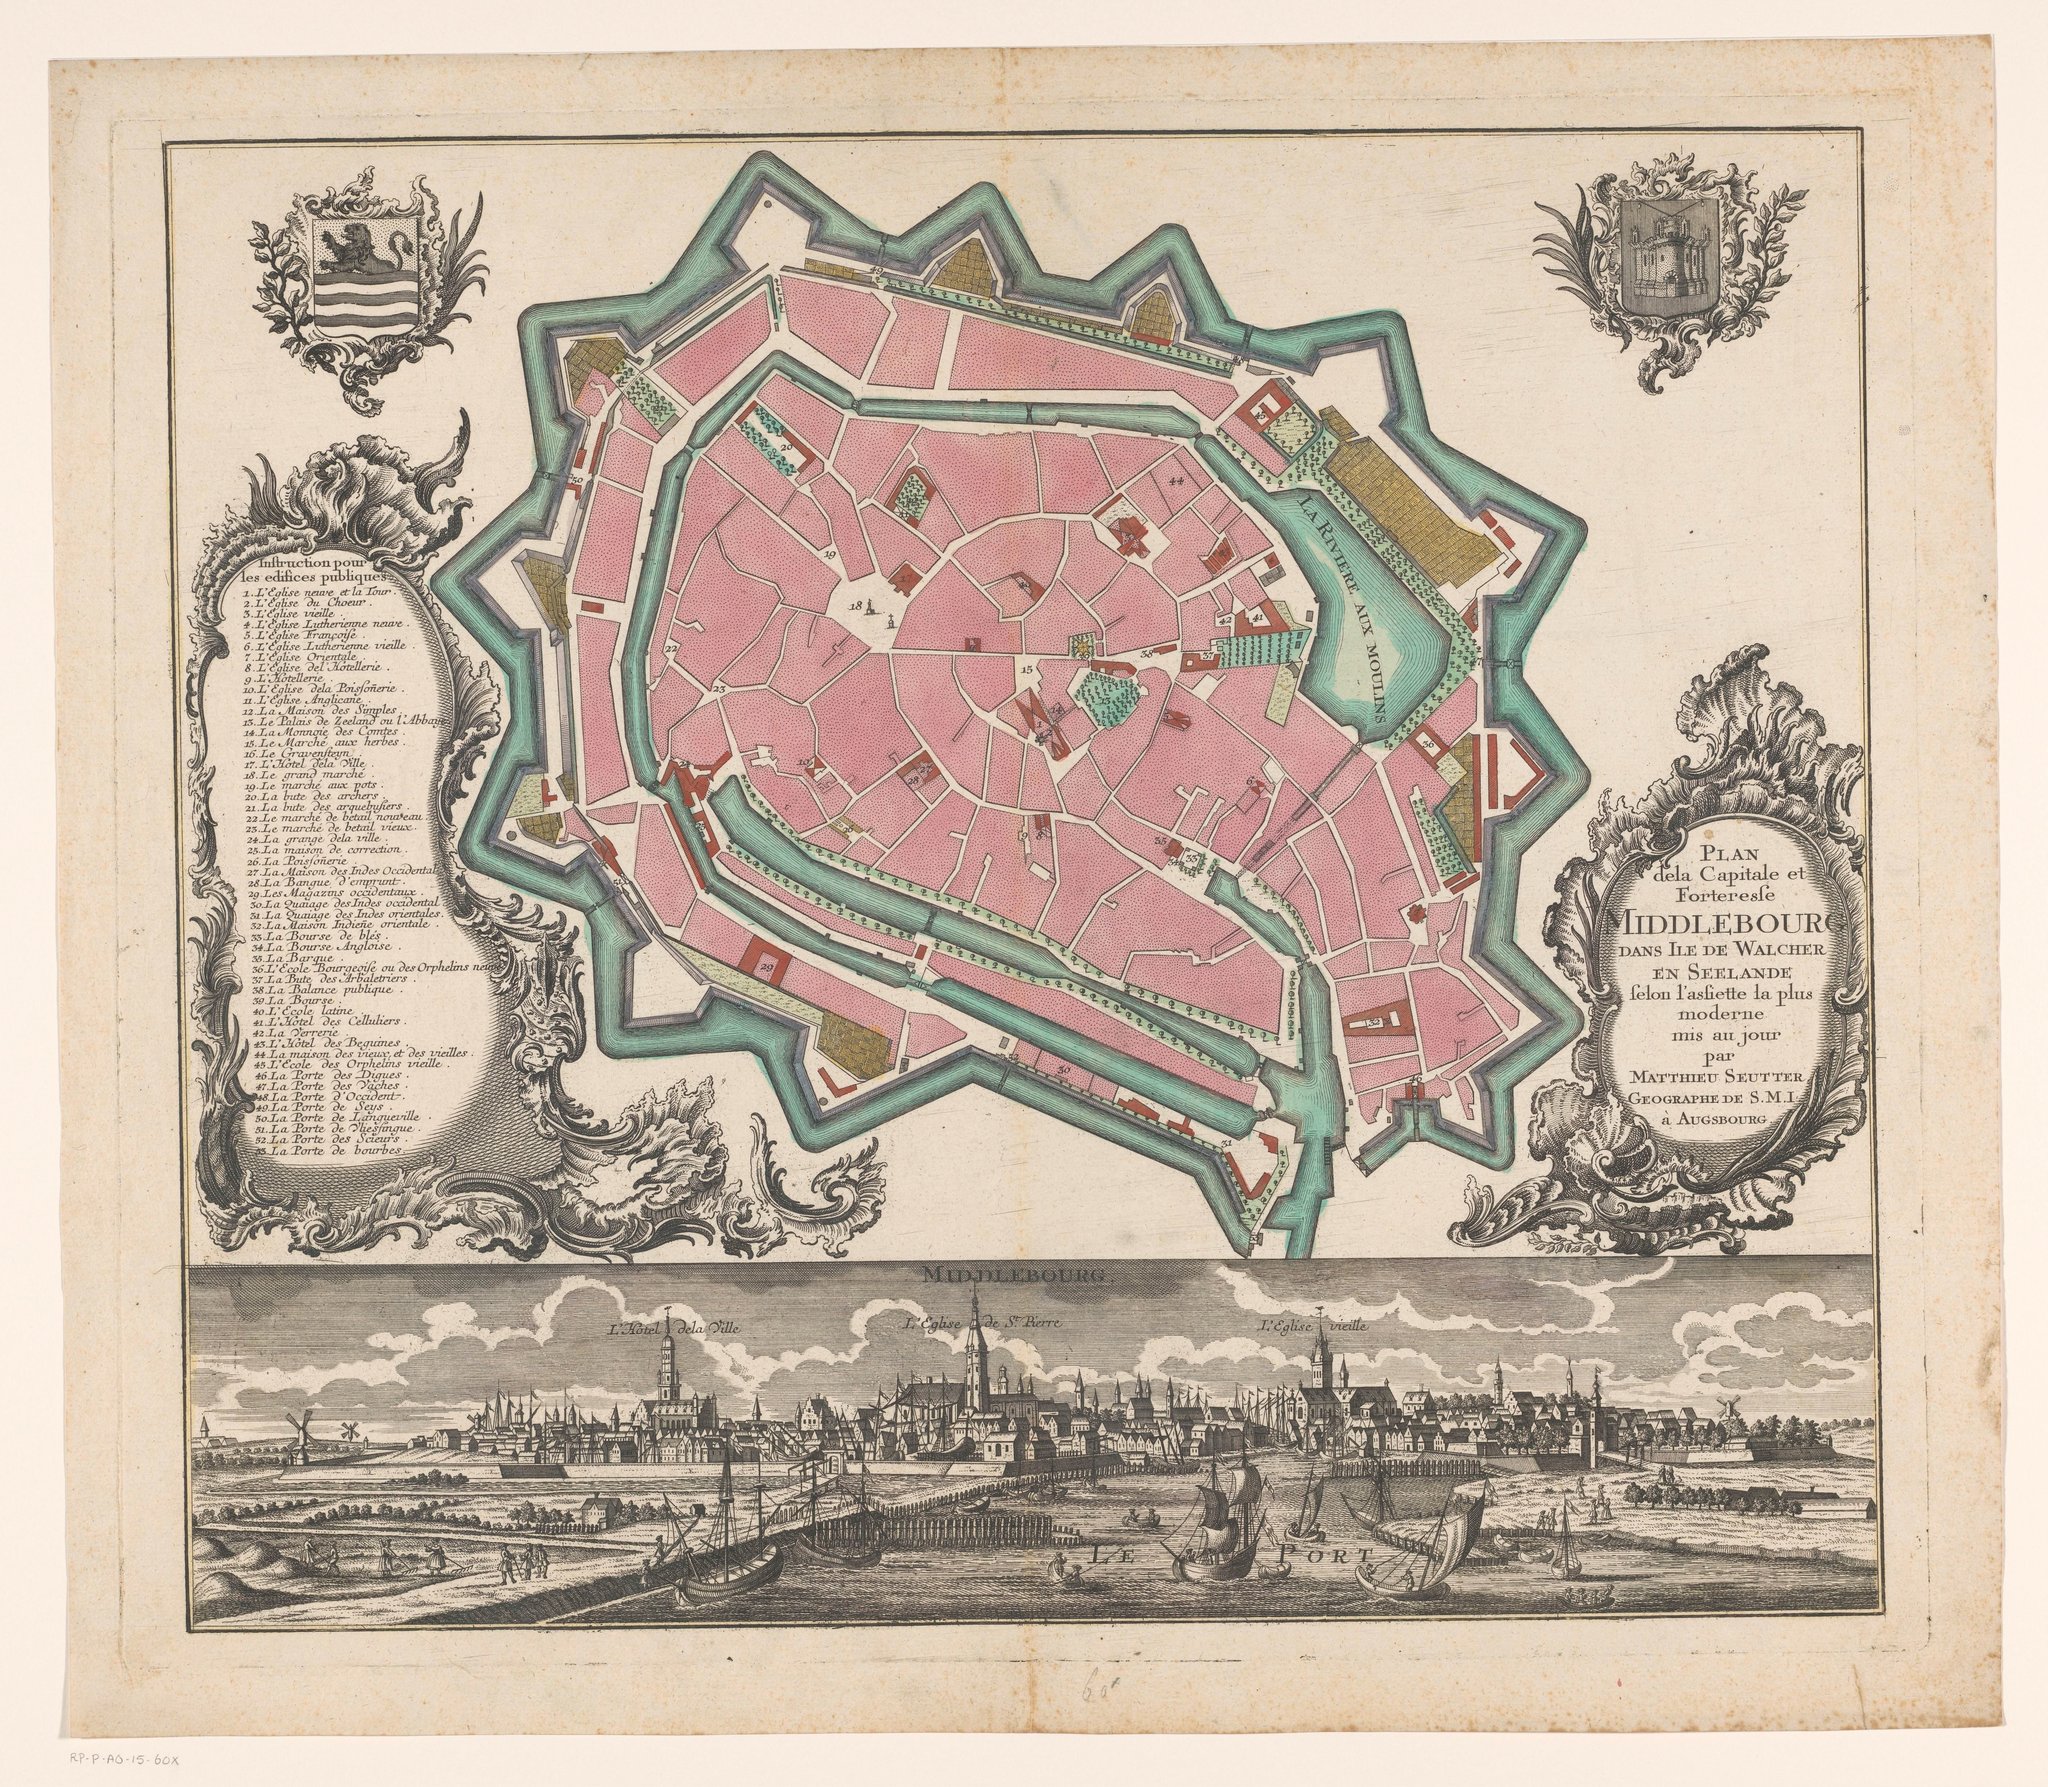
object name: print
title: Plattegrond van Middelburg met stadsgezicht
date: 1707-1757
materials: paper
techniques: engraving, etching, hand coloring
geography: augsburg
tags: coat of arms (as symbol of the state, etc.) (+ city; municipal), maps of cities, coat of arms (as symbol of the state, etc.) (+ province; provincial), middelburg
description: Linksboven het wapen van Zeeland met daaronder een cartouche met de legenda 1-53 in het Frans. Rechtsboven het wapen van Middelburg met een stuk daaronder de titelcartouche. Onder de plattegrond een gezicht op de stad, met op de voorgrond een deel van de haven.